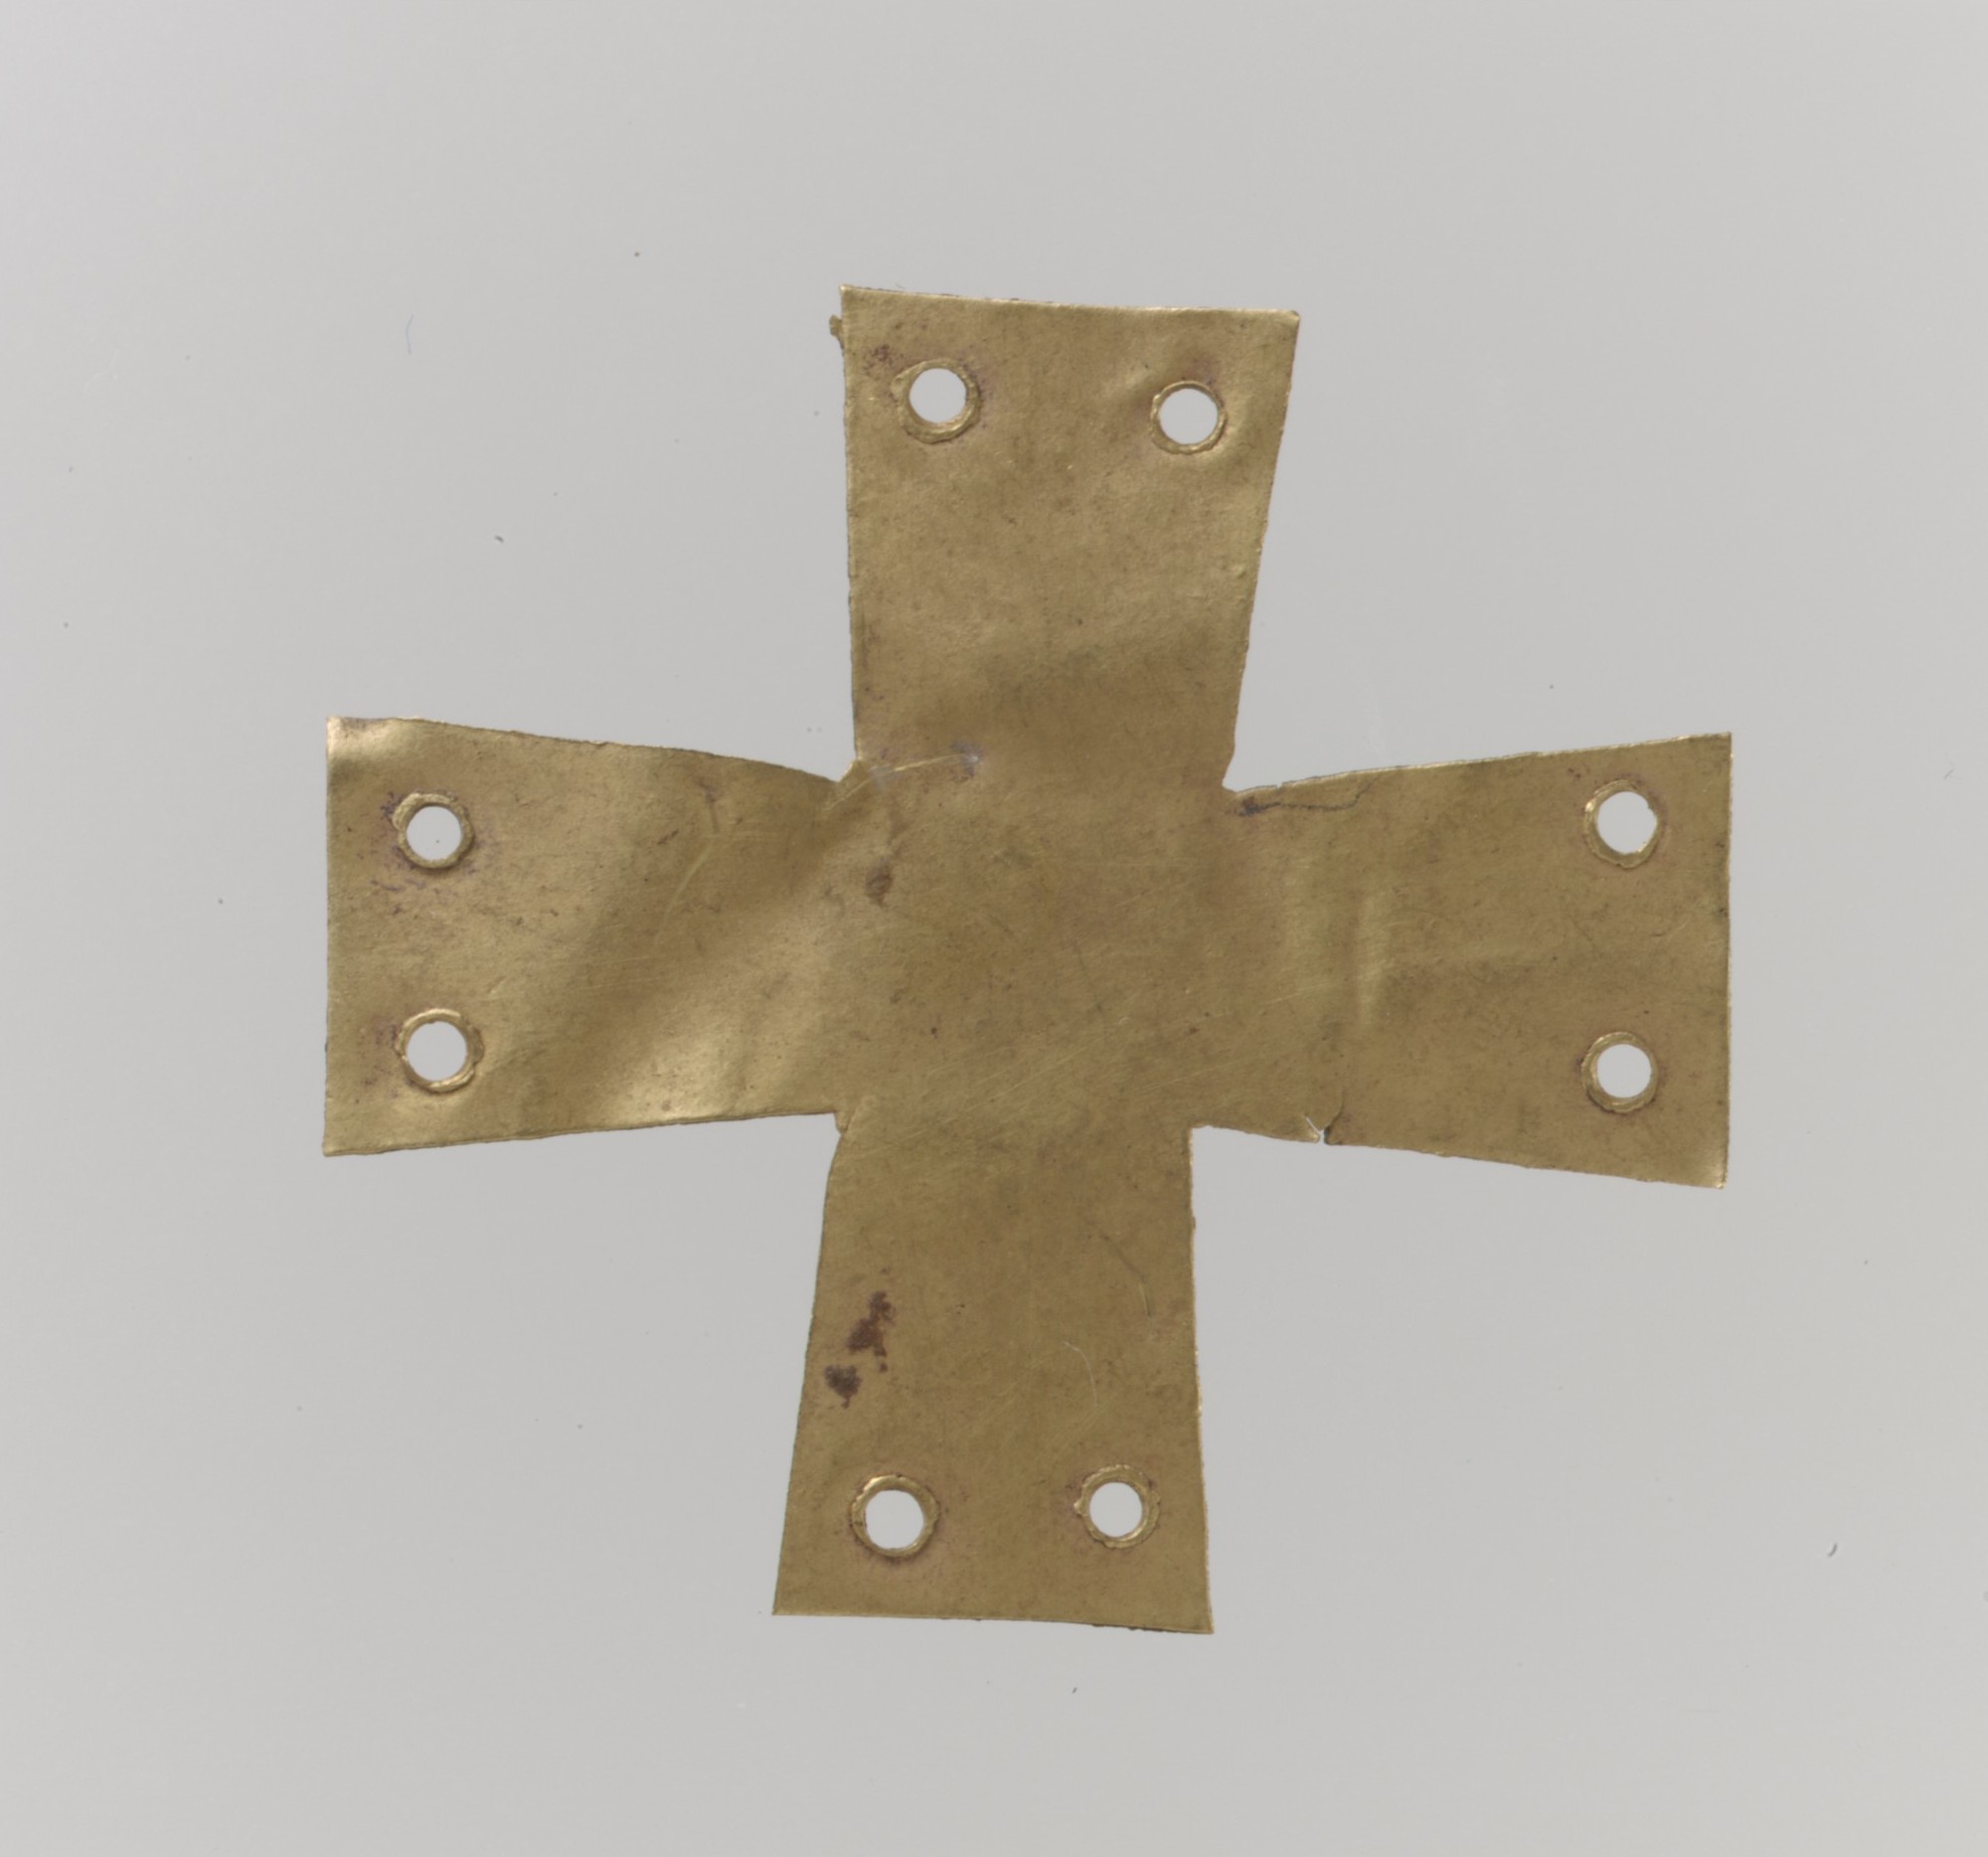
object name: appliqué cross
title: Gold Appliqué in the Form of a Cross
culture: langobardic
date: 600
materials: gold